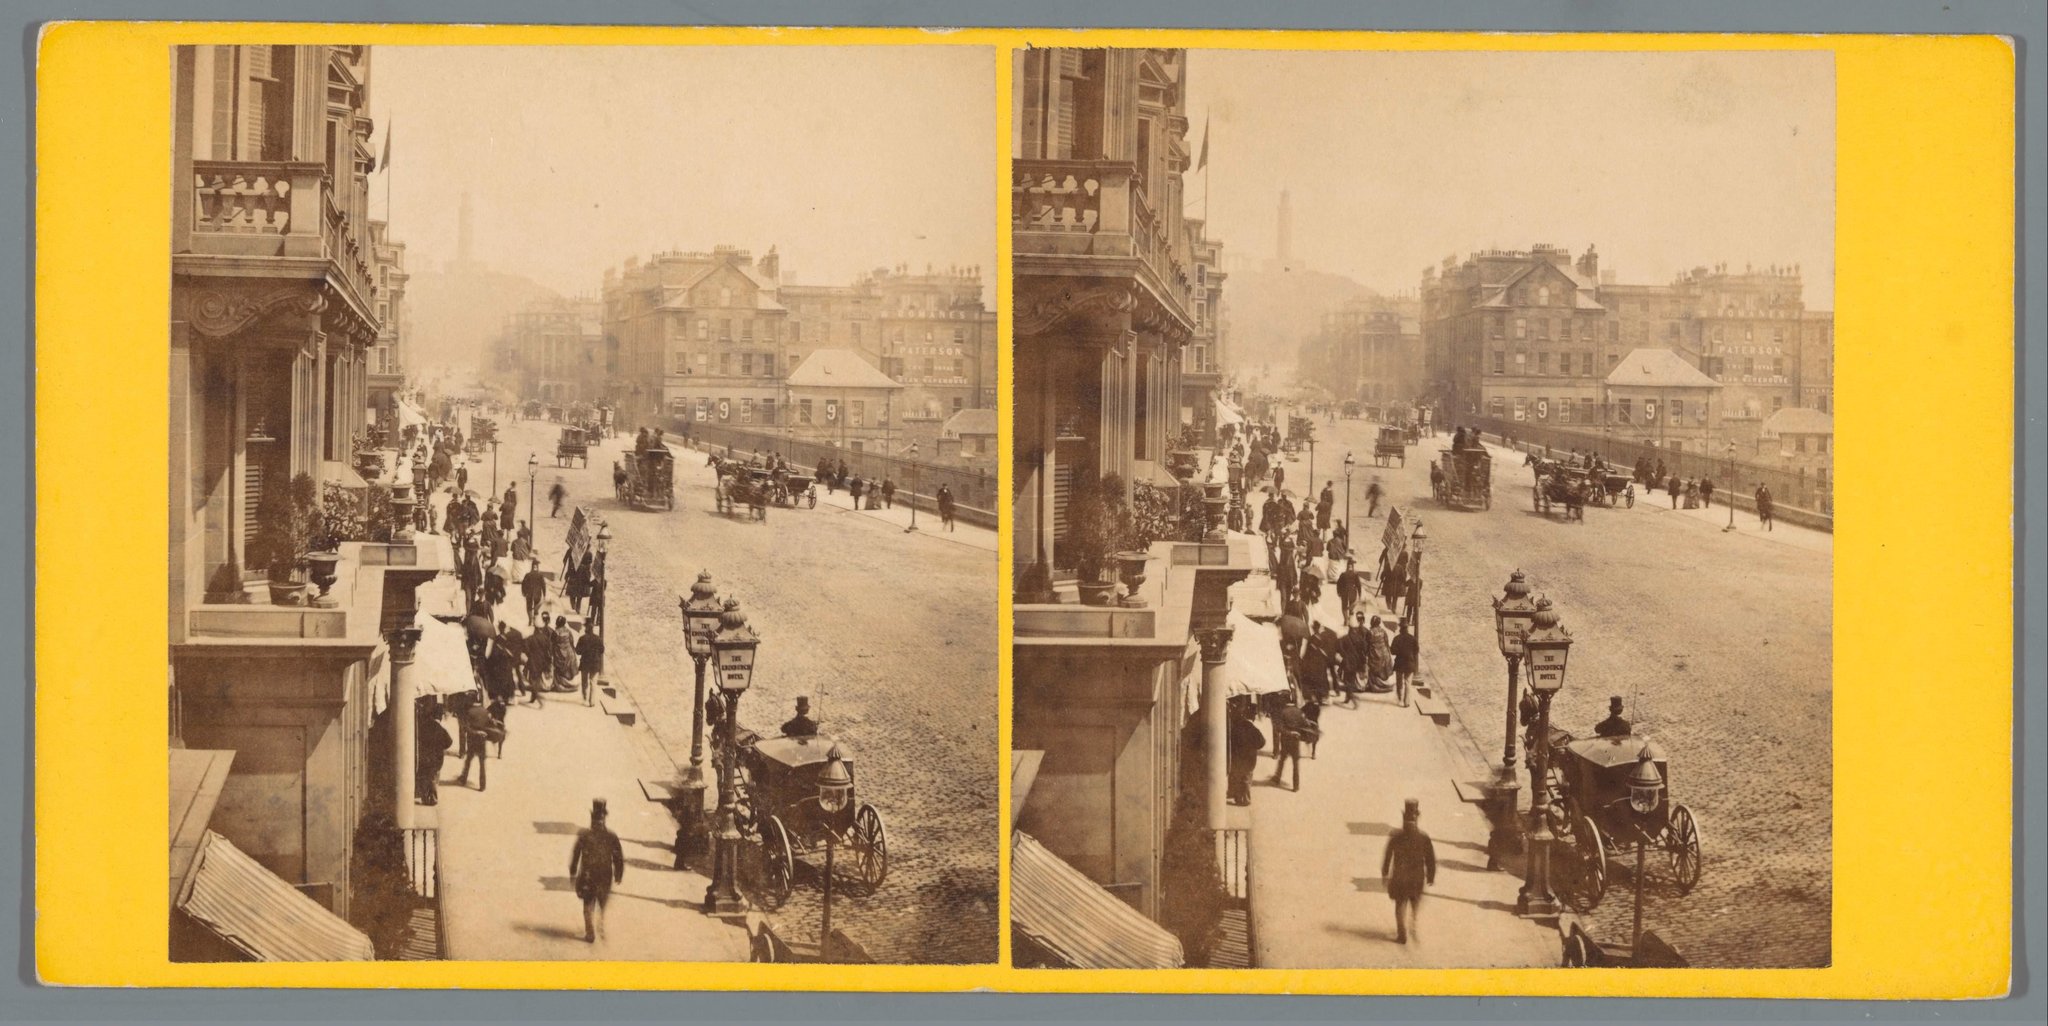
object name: stereograph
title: Edinburgh – Princes Street, looking towards the Calton Hill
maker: george washington wilson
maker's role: publisher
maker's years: 1823-1893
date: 1860-1865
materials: cardboard, photographic support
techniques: albumen print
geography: aberdeen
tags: schotland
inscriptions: label: ‘G.W. Wilson & Co, Aberdeen No. 187 Edinburgh – Princes Street, looking towards the Calton Hill’